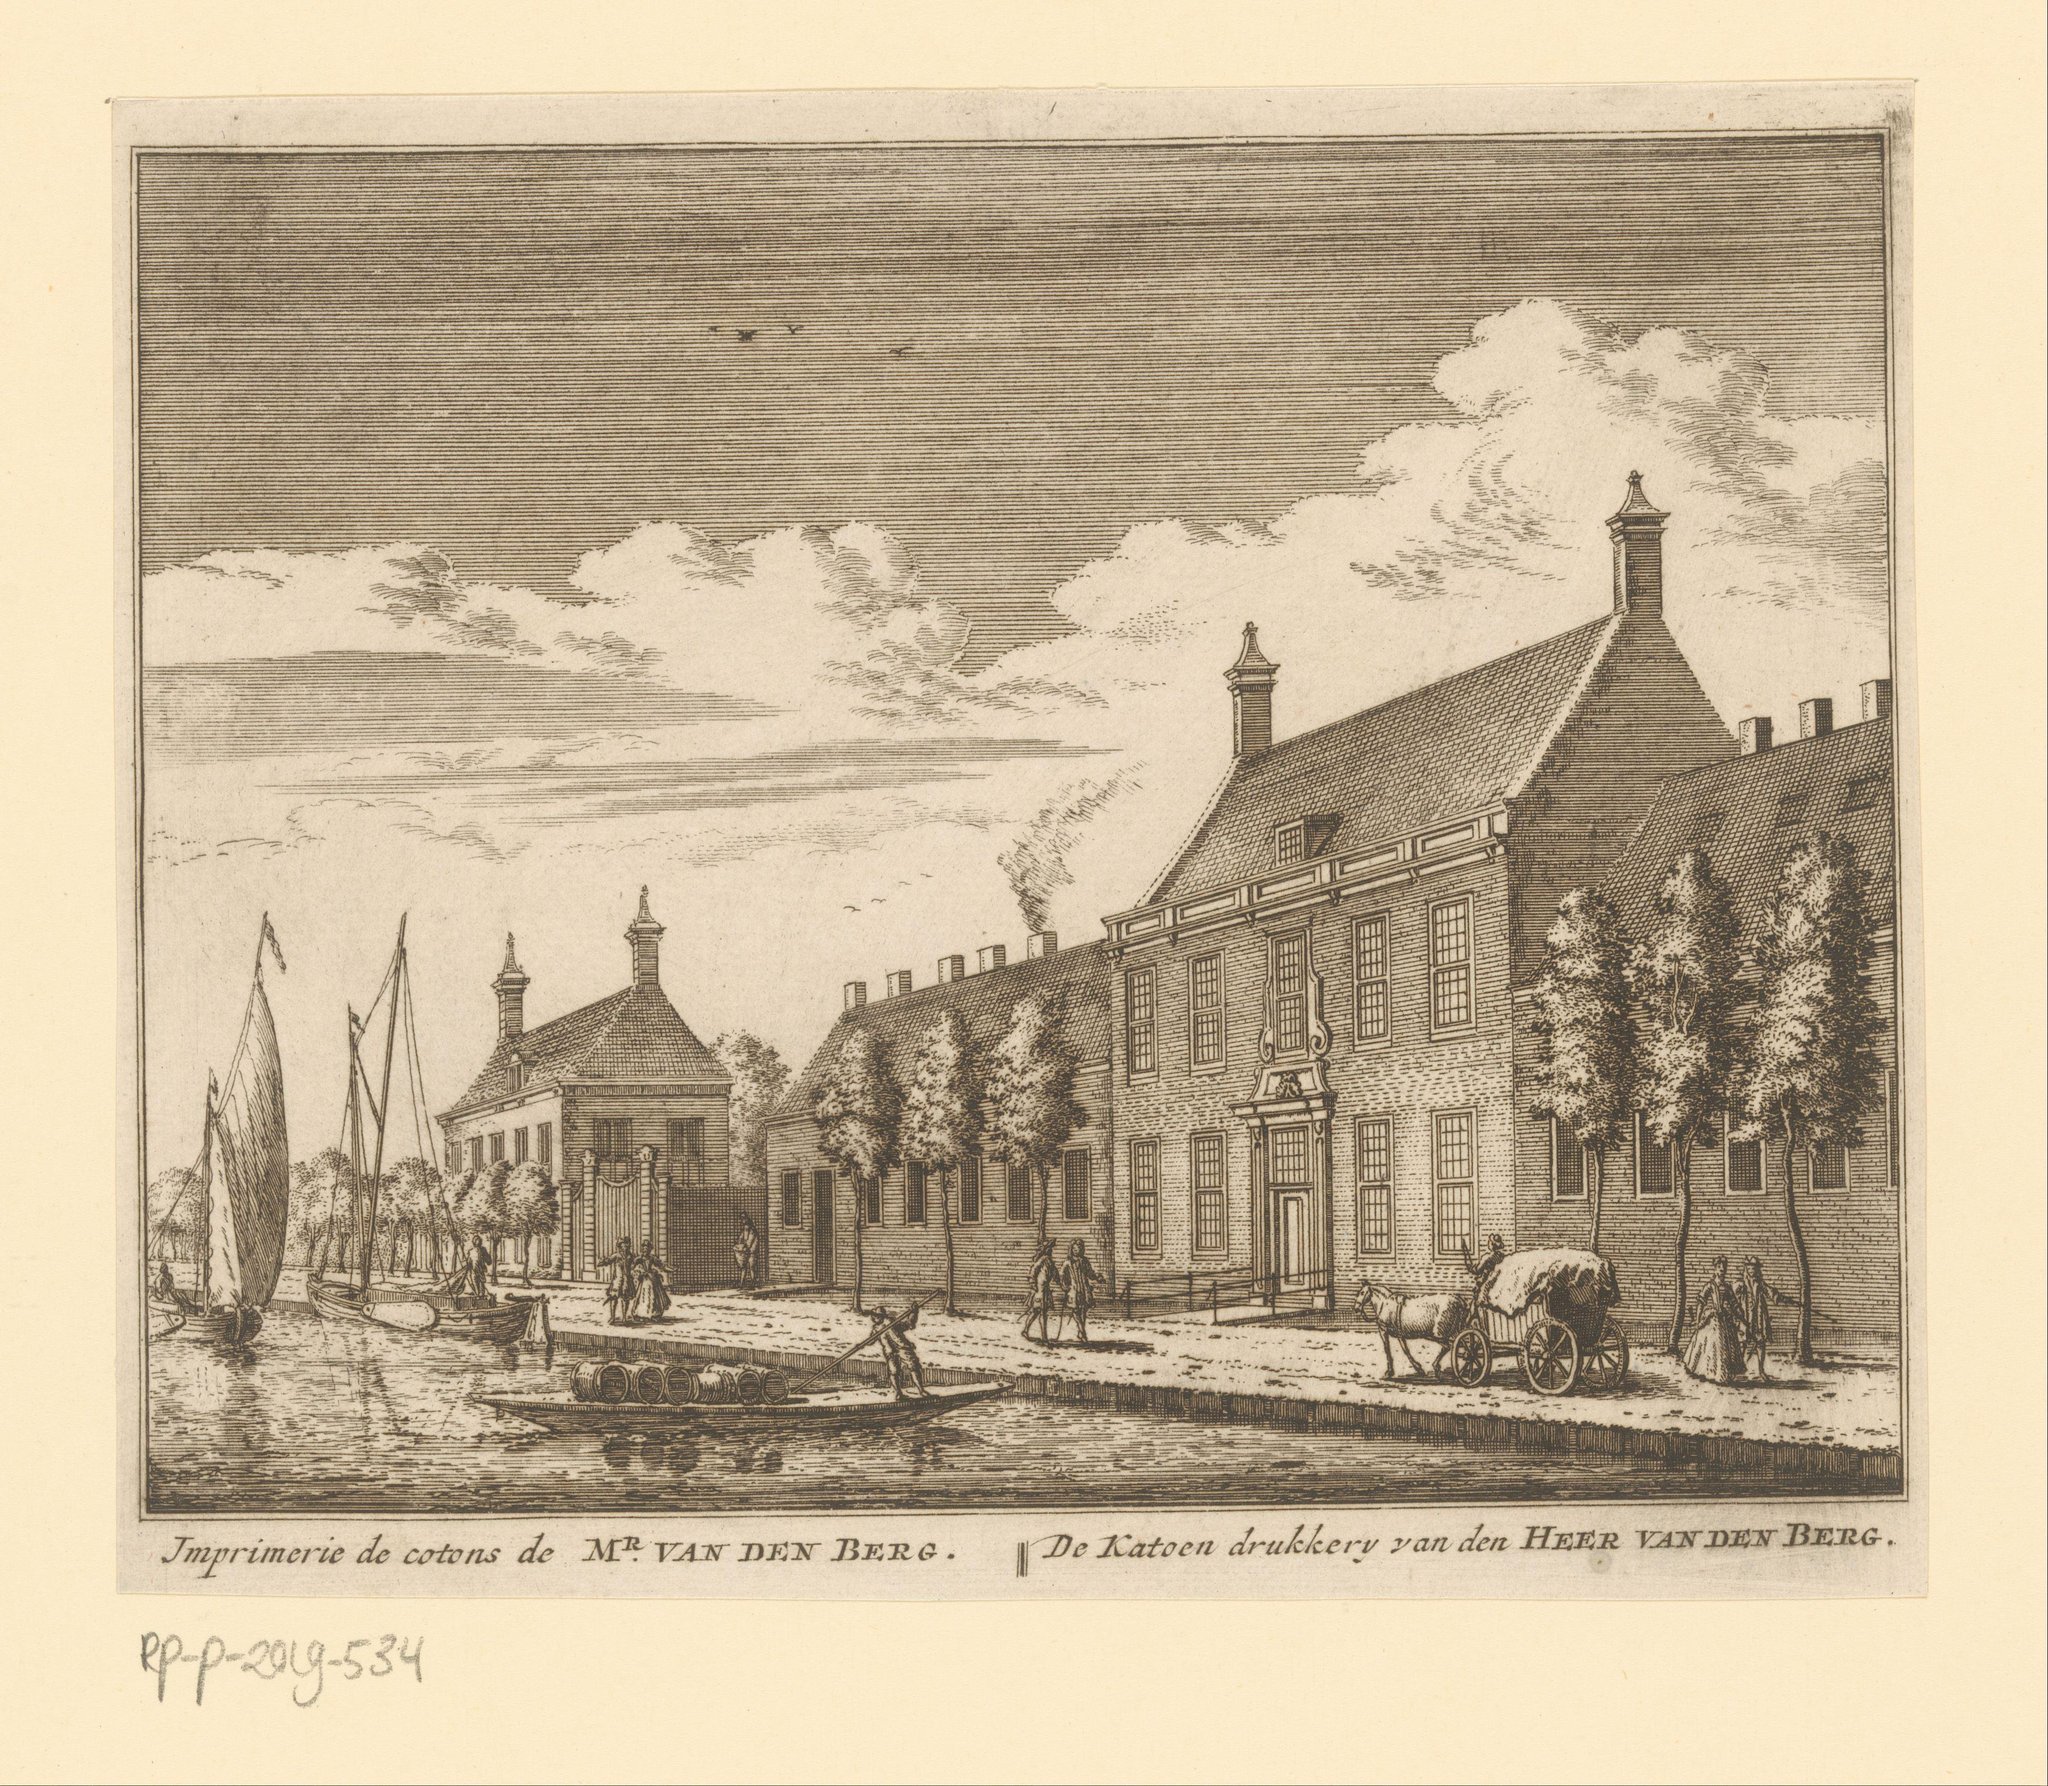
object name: print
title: Imprimerie de cotons de Mr. Van den Berg / De Katoen drukkery van den Heer van den Berg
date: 1730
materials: paper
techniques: etching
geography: amsterdam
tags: cotton (material ~ textile industry)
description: Prent mogelijk uit: Hollandse Arkadia. Amsterdam: Leonard Schenk, 1730.